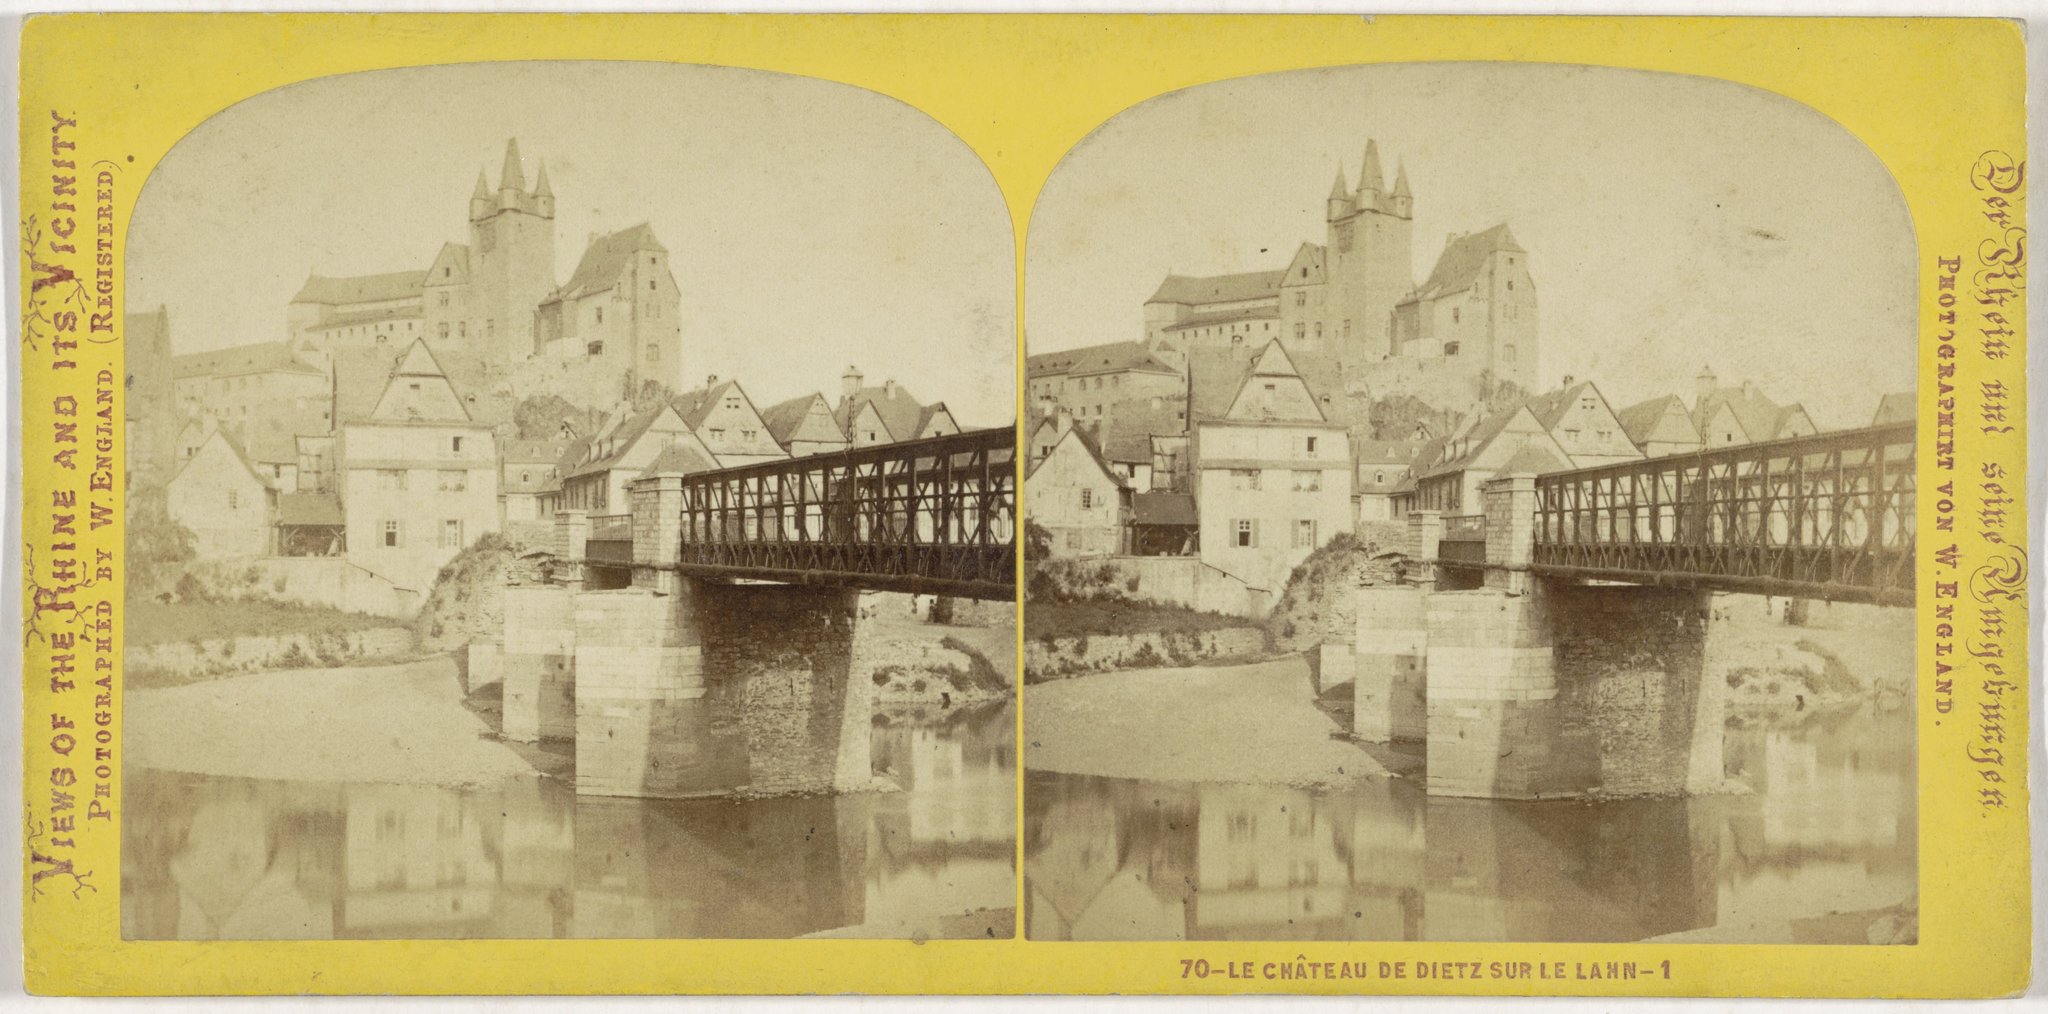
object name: stereograph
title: Grafelijke slot in Diez aan de Lahn, Duitsland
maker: william england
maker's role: fotograaf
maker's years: 1816-1896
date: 1867-1868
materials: cardboard, paper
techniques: albumen print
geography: diez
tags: castle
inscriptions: number: ‘70’